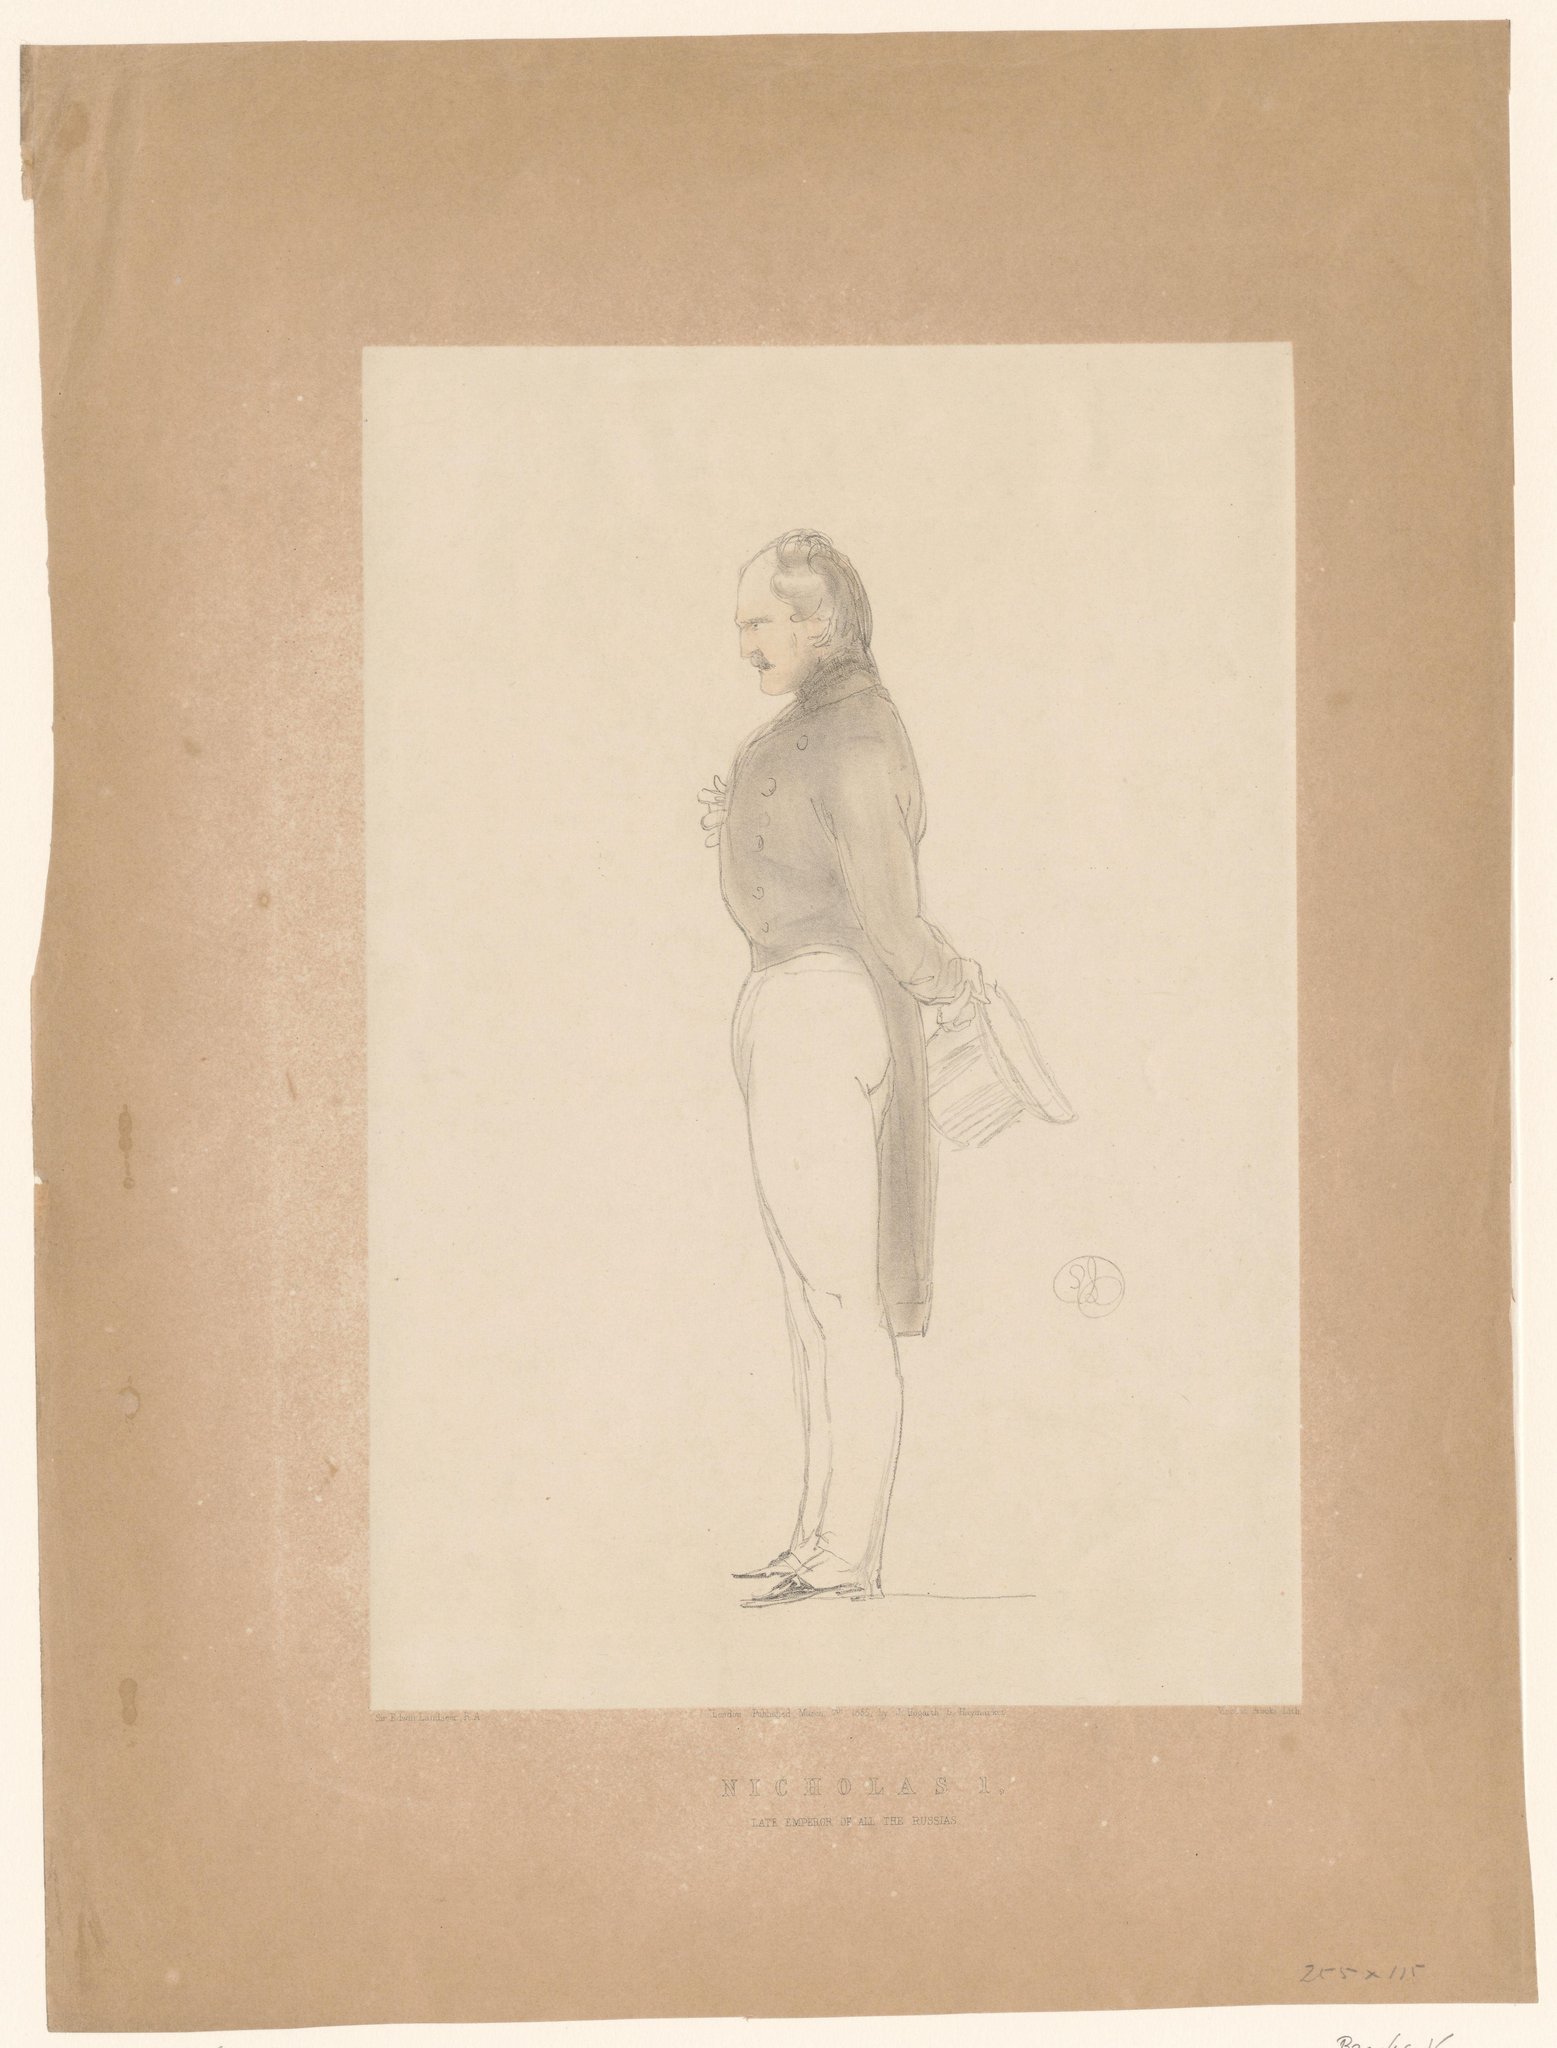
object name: print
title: Nicholas I, late emperor of all the Russias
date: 1855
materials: paper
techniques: tone lithography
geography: london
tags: head-gear, moustache, adult man, historical persons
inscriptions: collector's mark: Lugt 2228